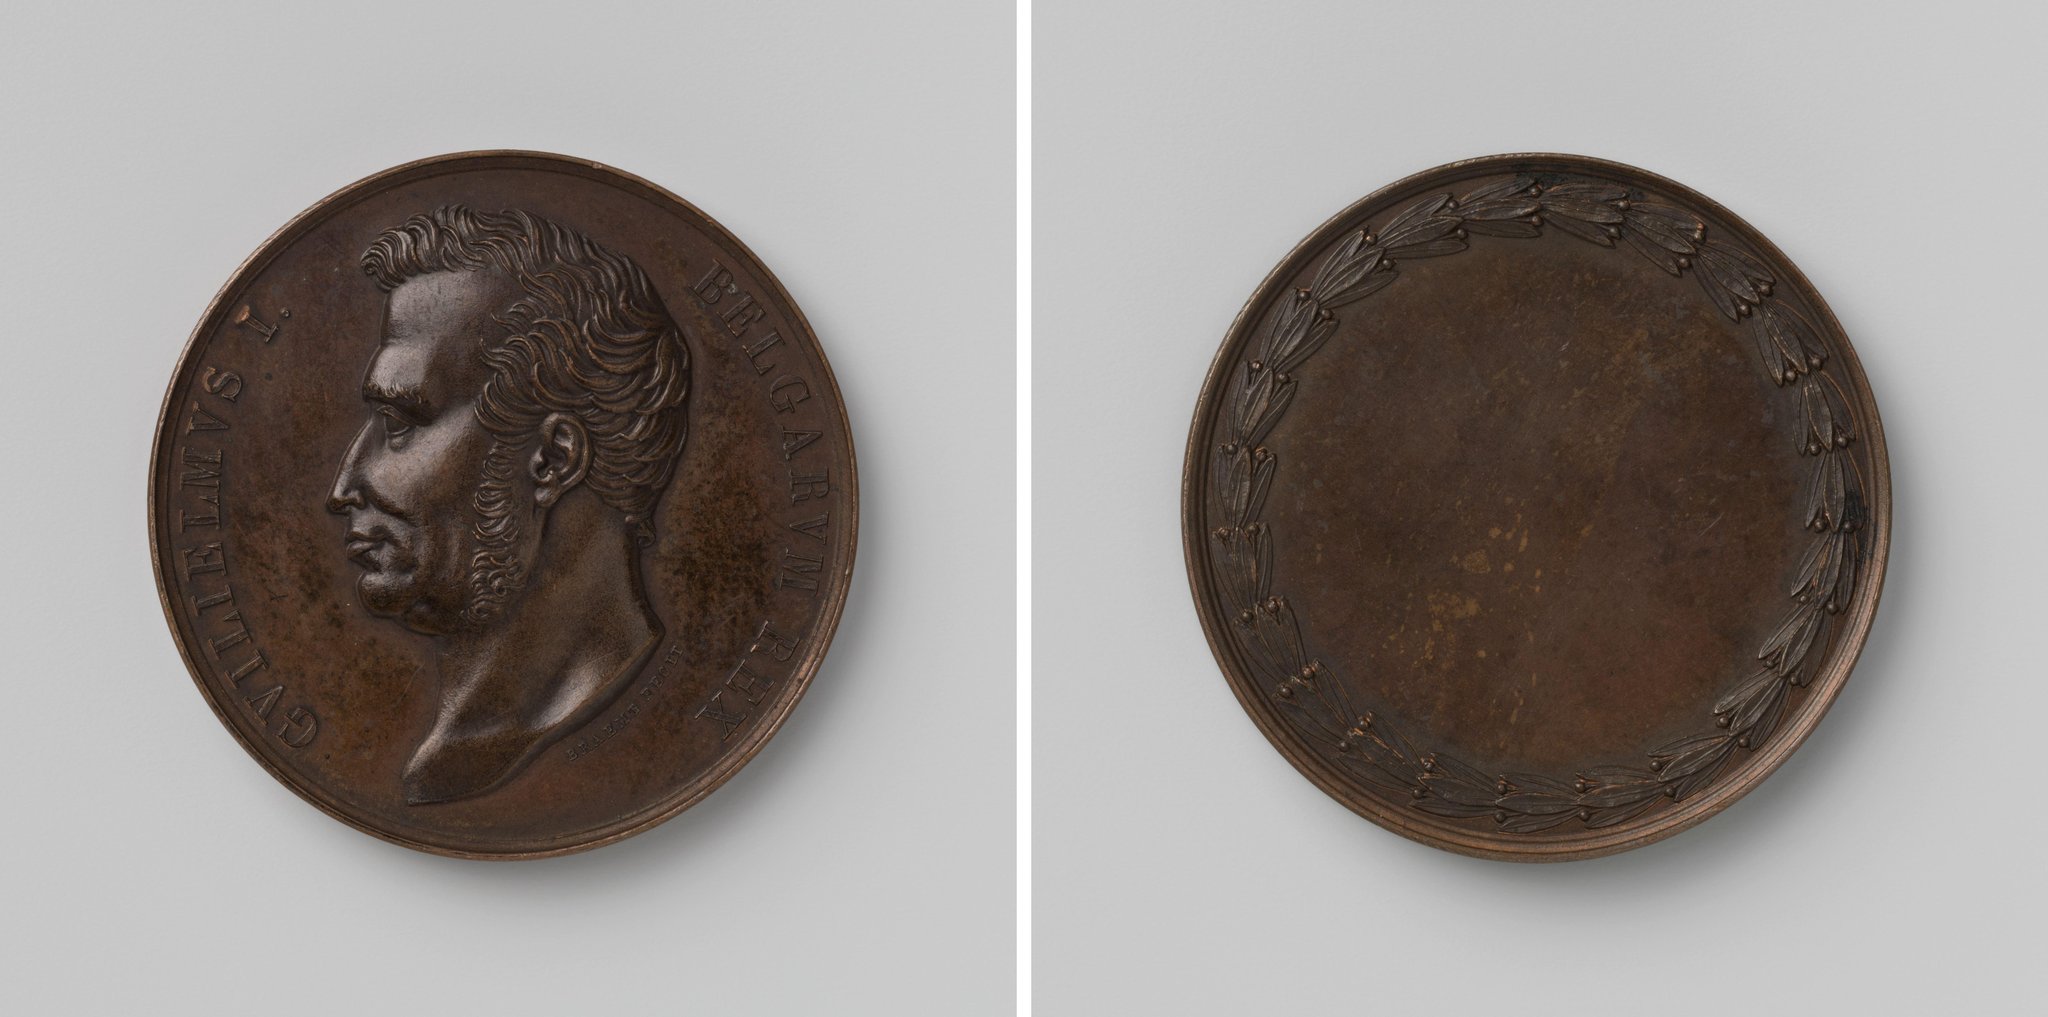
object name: medal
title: Willem I, koning der Nederlanden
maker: joseph pierre braemt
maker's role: print maker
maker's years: 1796-1864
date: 1817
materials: bronze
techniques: striking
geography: brussels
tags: the hague, berlin, william i of the netherlands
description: Bronzen penning. Voorzijde: borststuk man binnen omschrift. Keerzijde: blanco veld binnen krans van olijftakken